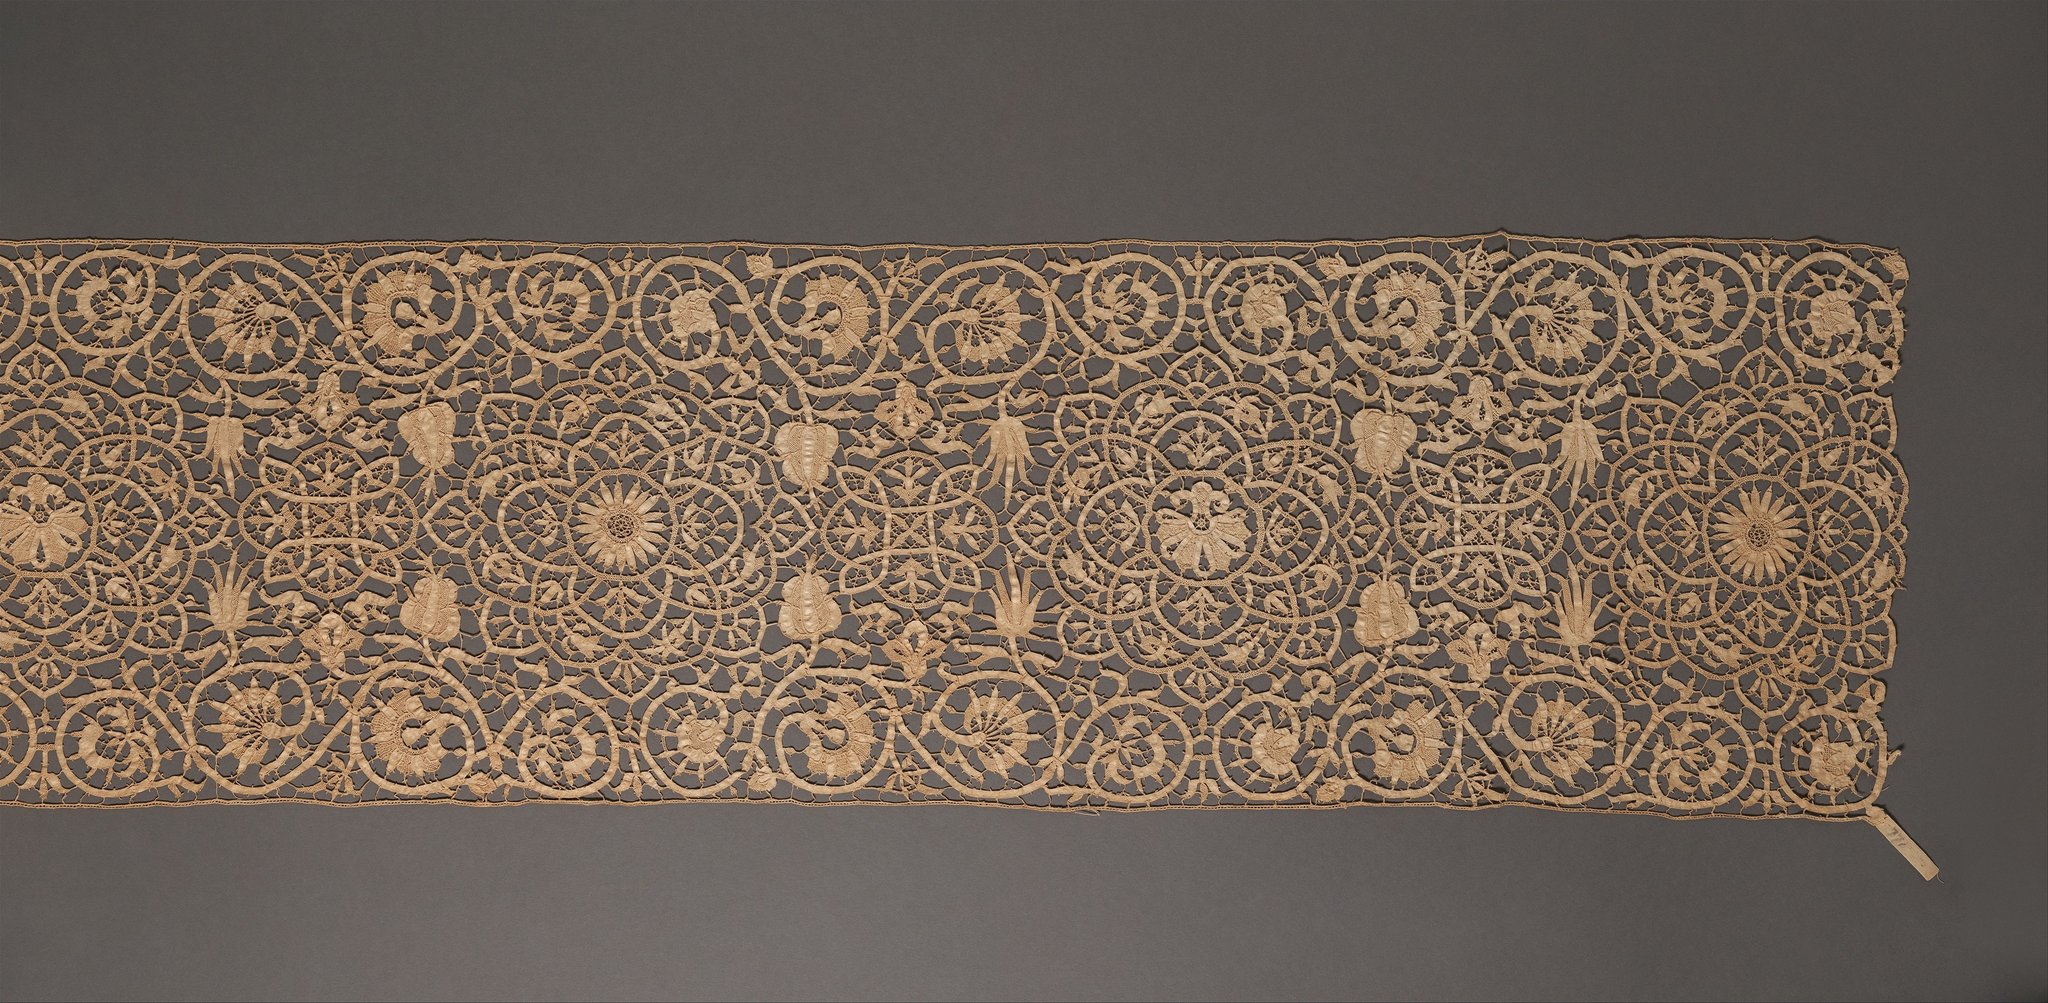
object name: border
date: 1601-1633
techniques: lace